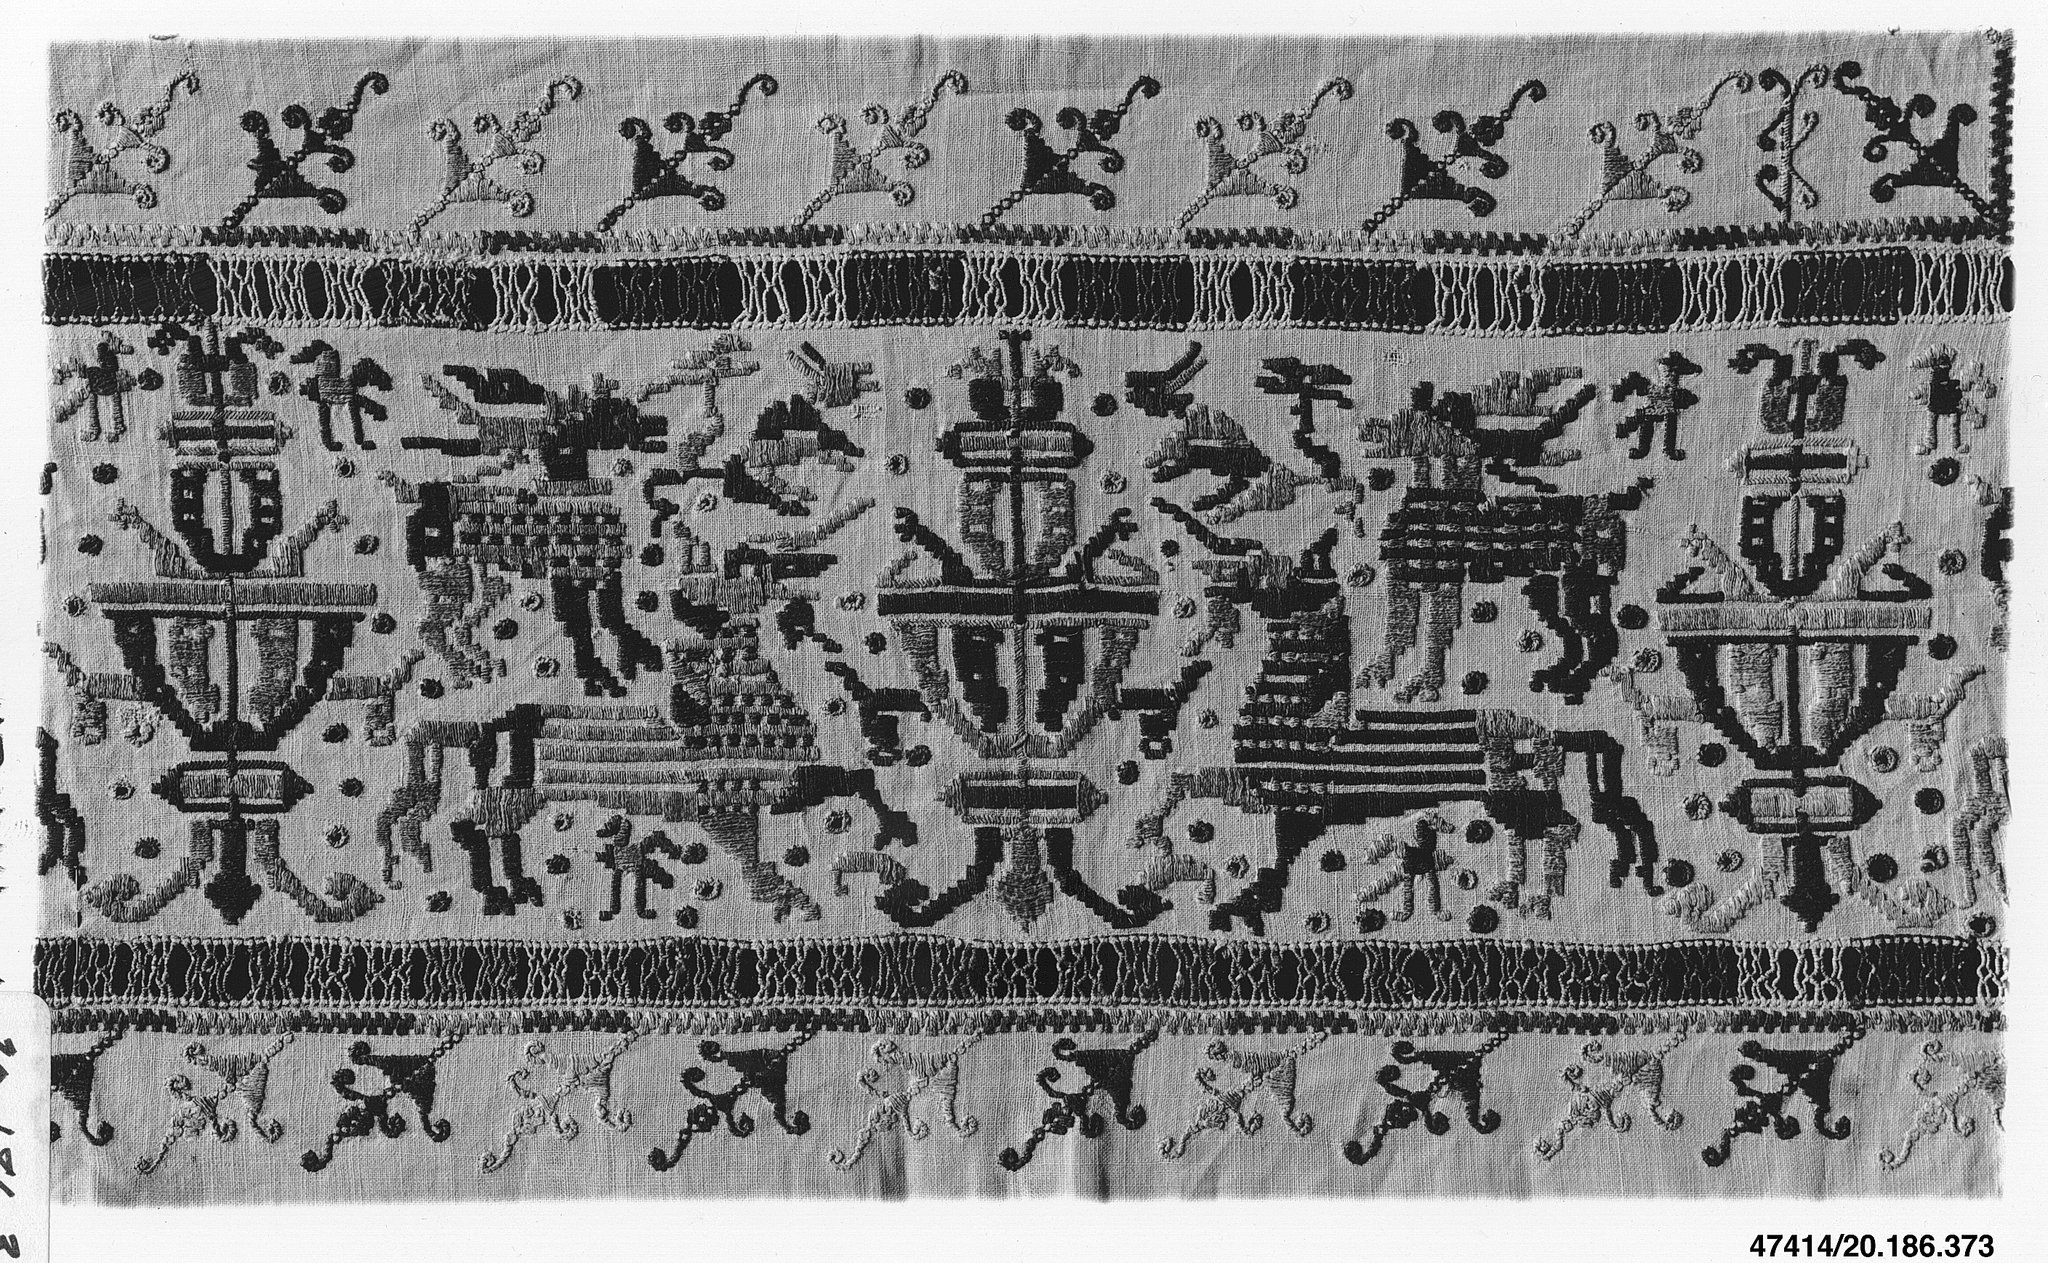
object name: altar cloth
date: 1501-1533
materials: linen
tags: deer